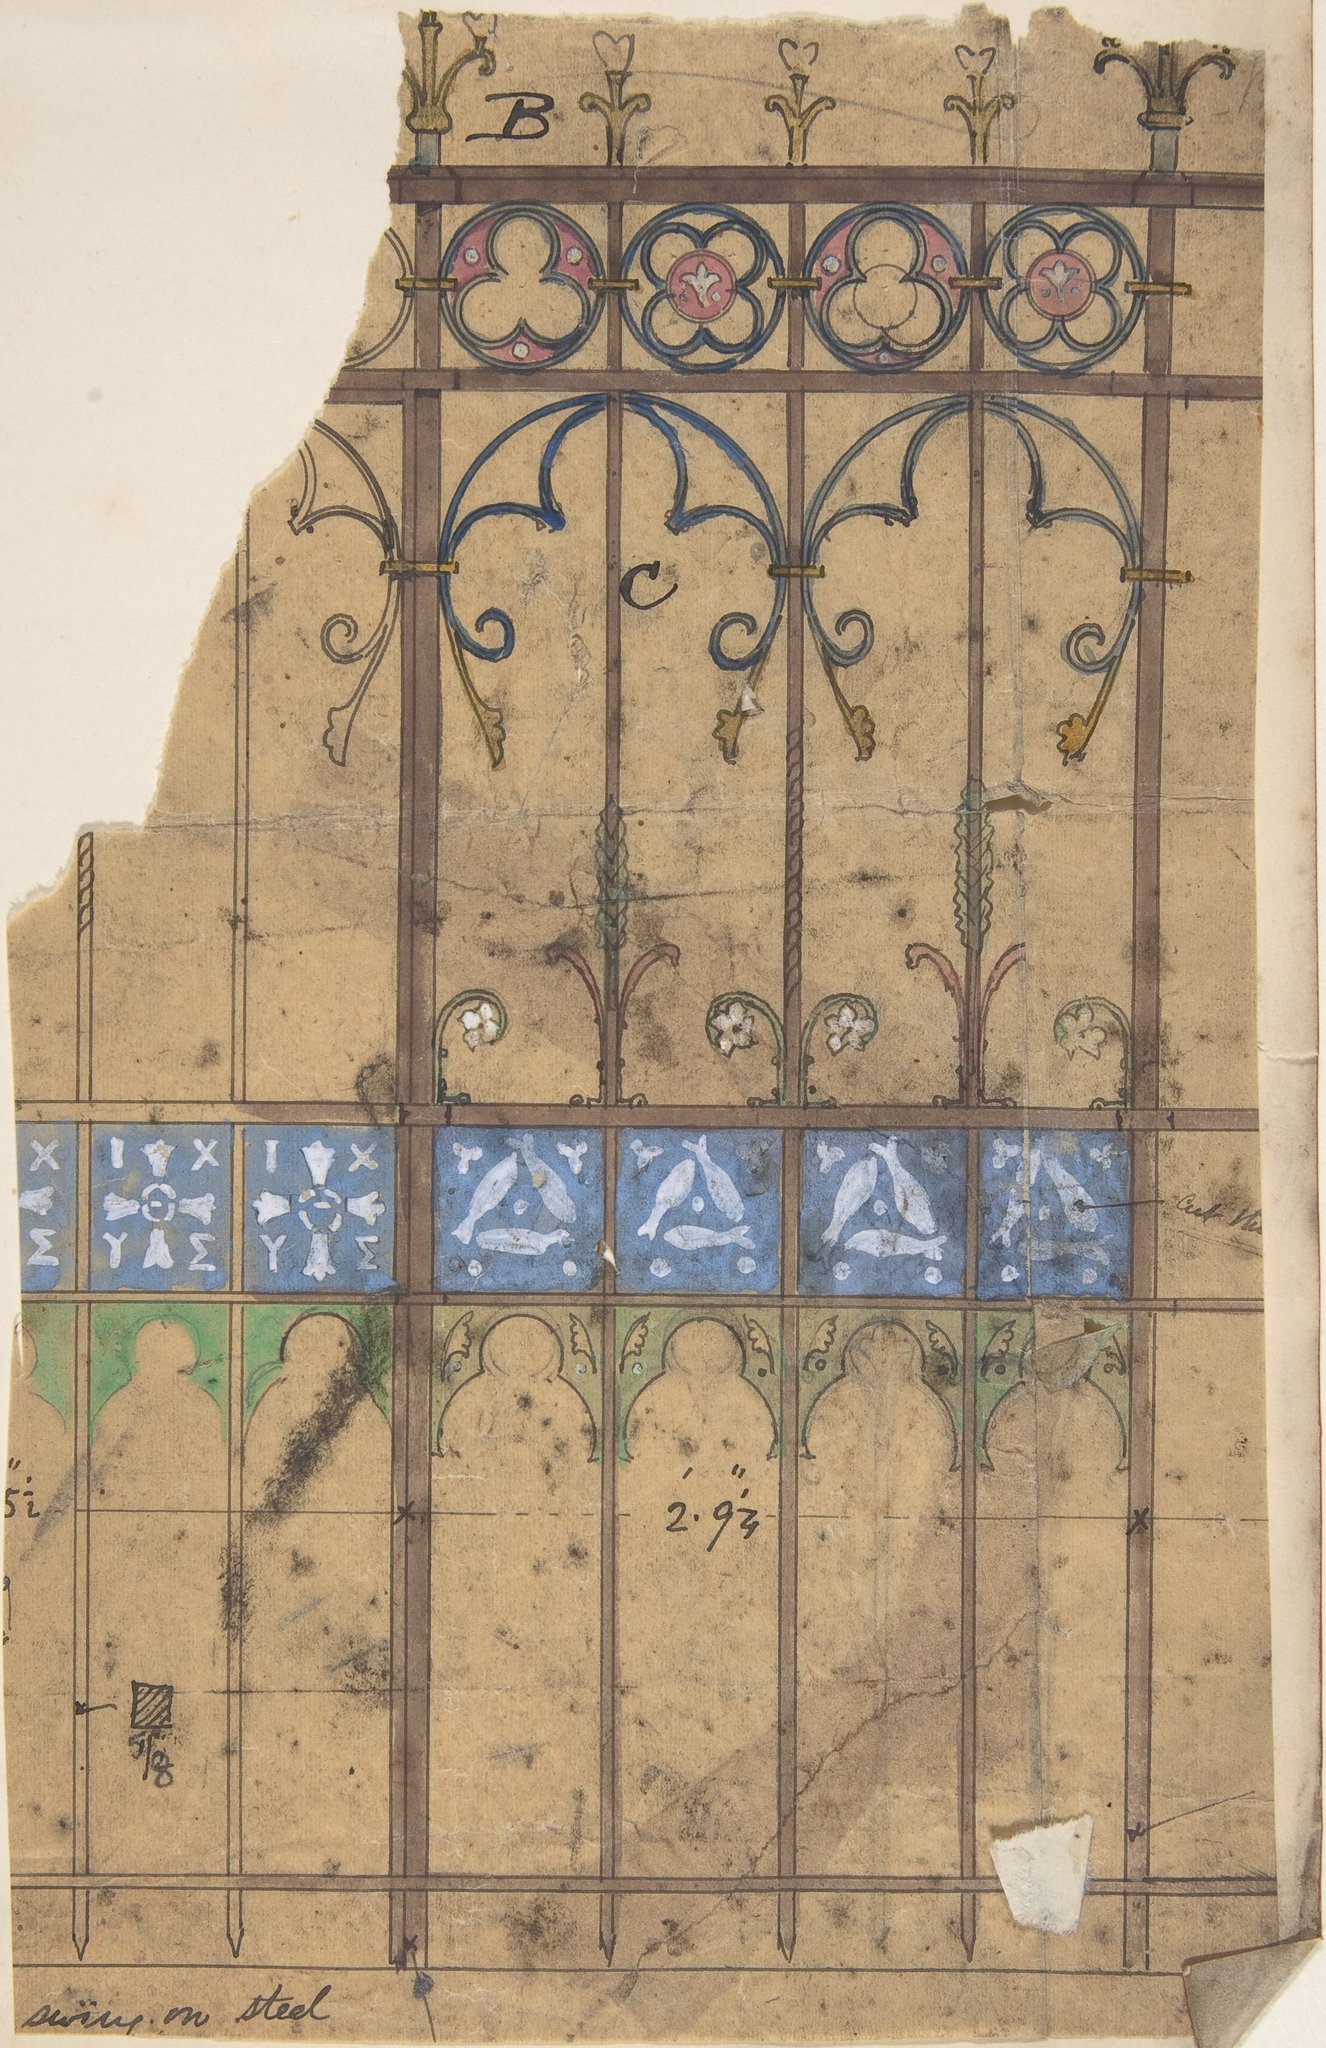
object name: drawing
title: Design for a Church Gate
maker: richardson ellson & co.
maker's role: artist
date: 1880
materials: ink, watercolor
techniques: brush, pen, wash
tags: gates